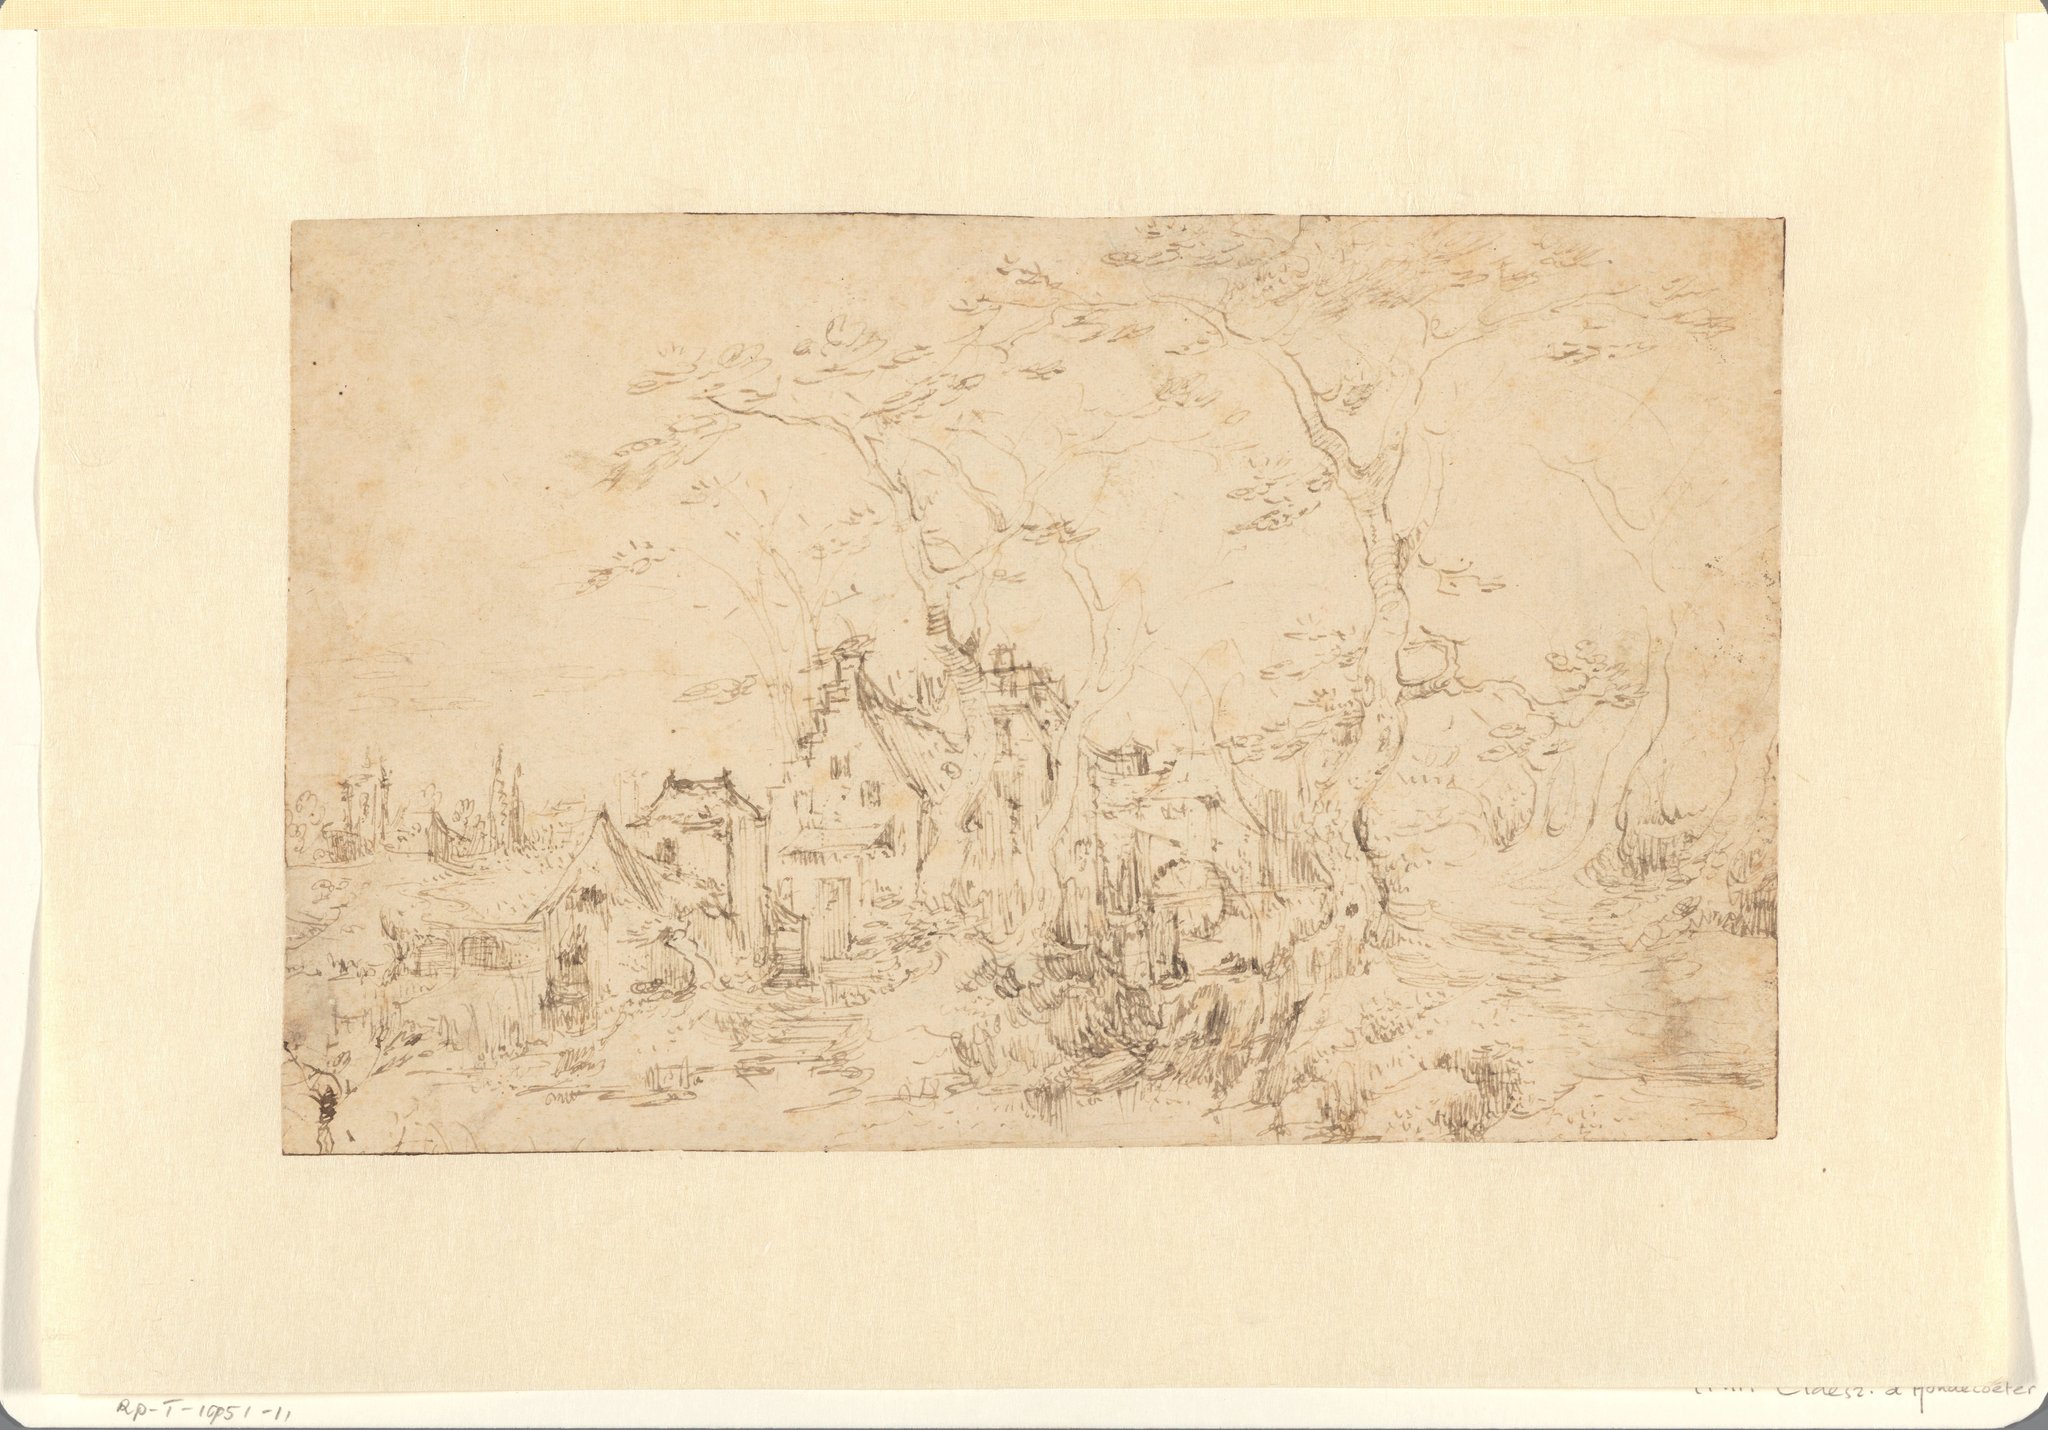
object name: drawing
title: Huizen en watermolen tussen hoge bomen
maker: gillis claesz de hondecoeter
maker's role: draughtsman, painter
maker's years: 1575-1638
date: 1580-1638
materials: ink, paper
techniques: pen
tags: watermill in landscape